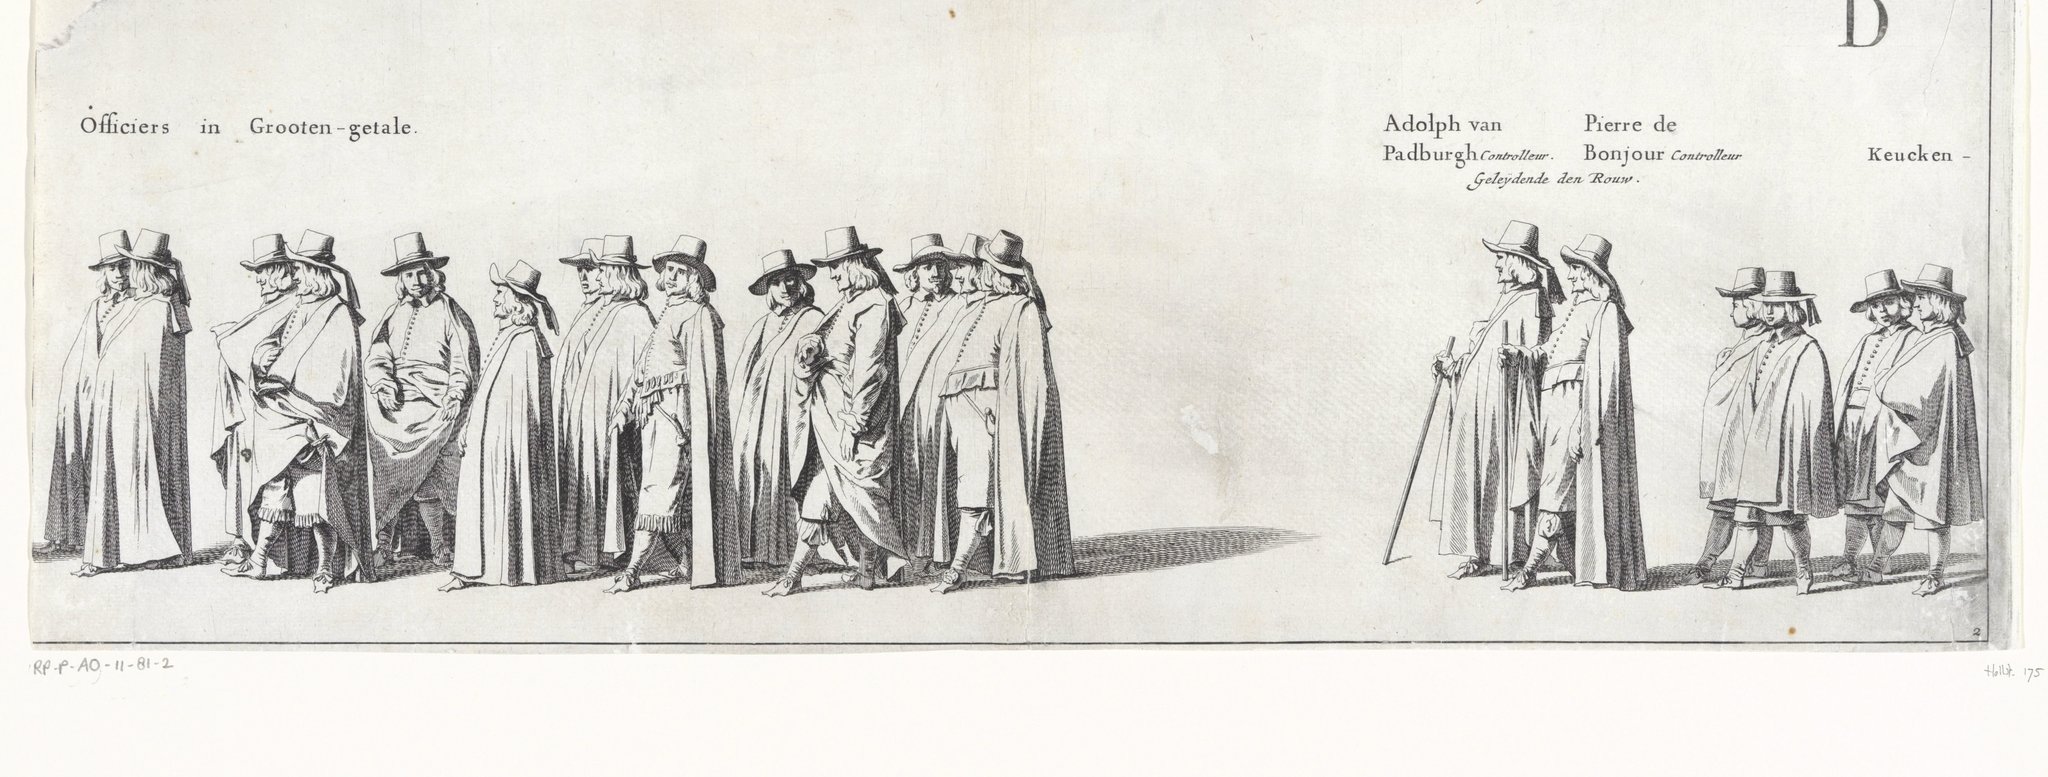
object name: print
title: De begrafenisstoet van Frederik Hendrik (plaat nr. 2), 1647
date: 1651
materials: paper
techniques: engraving, etching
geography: the hague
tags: cortege, funeral procession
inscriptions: collector's mark: Lugt 2228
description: De begrafenisstoet van stadhouder Frederik Hendrik te 's-Gravenhage op 10 mei 1647. Plaat nr. 2 met een deel van de stoet, boven de personen staat hun functie. Onderdeel van een serie van 30 platen en 20 tekstbladen, bedoeld om aan elkaar geplakt te worden.